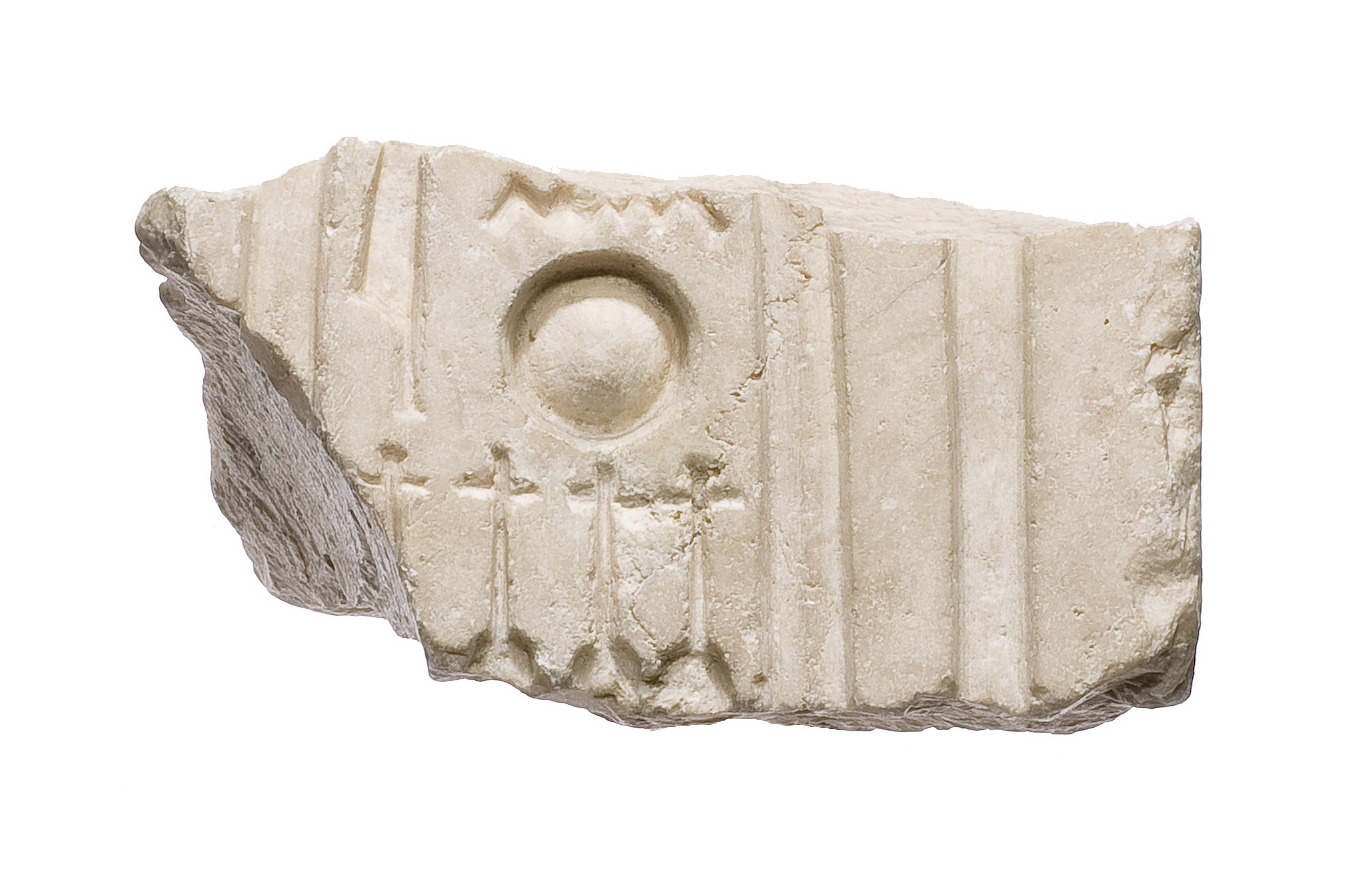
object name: pillar, nefertiti cartouche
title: Inscribed element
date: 1353-1336 BCE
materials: limestone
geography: egypt